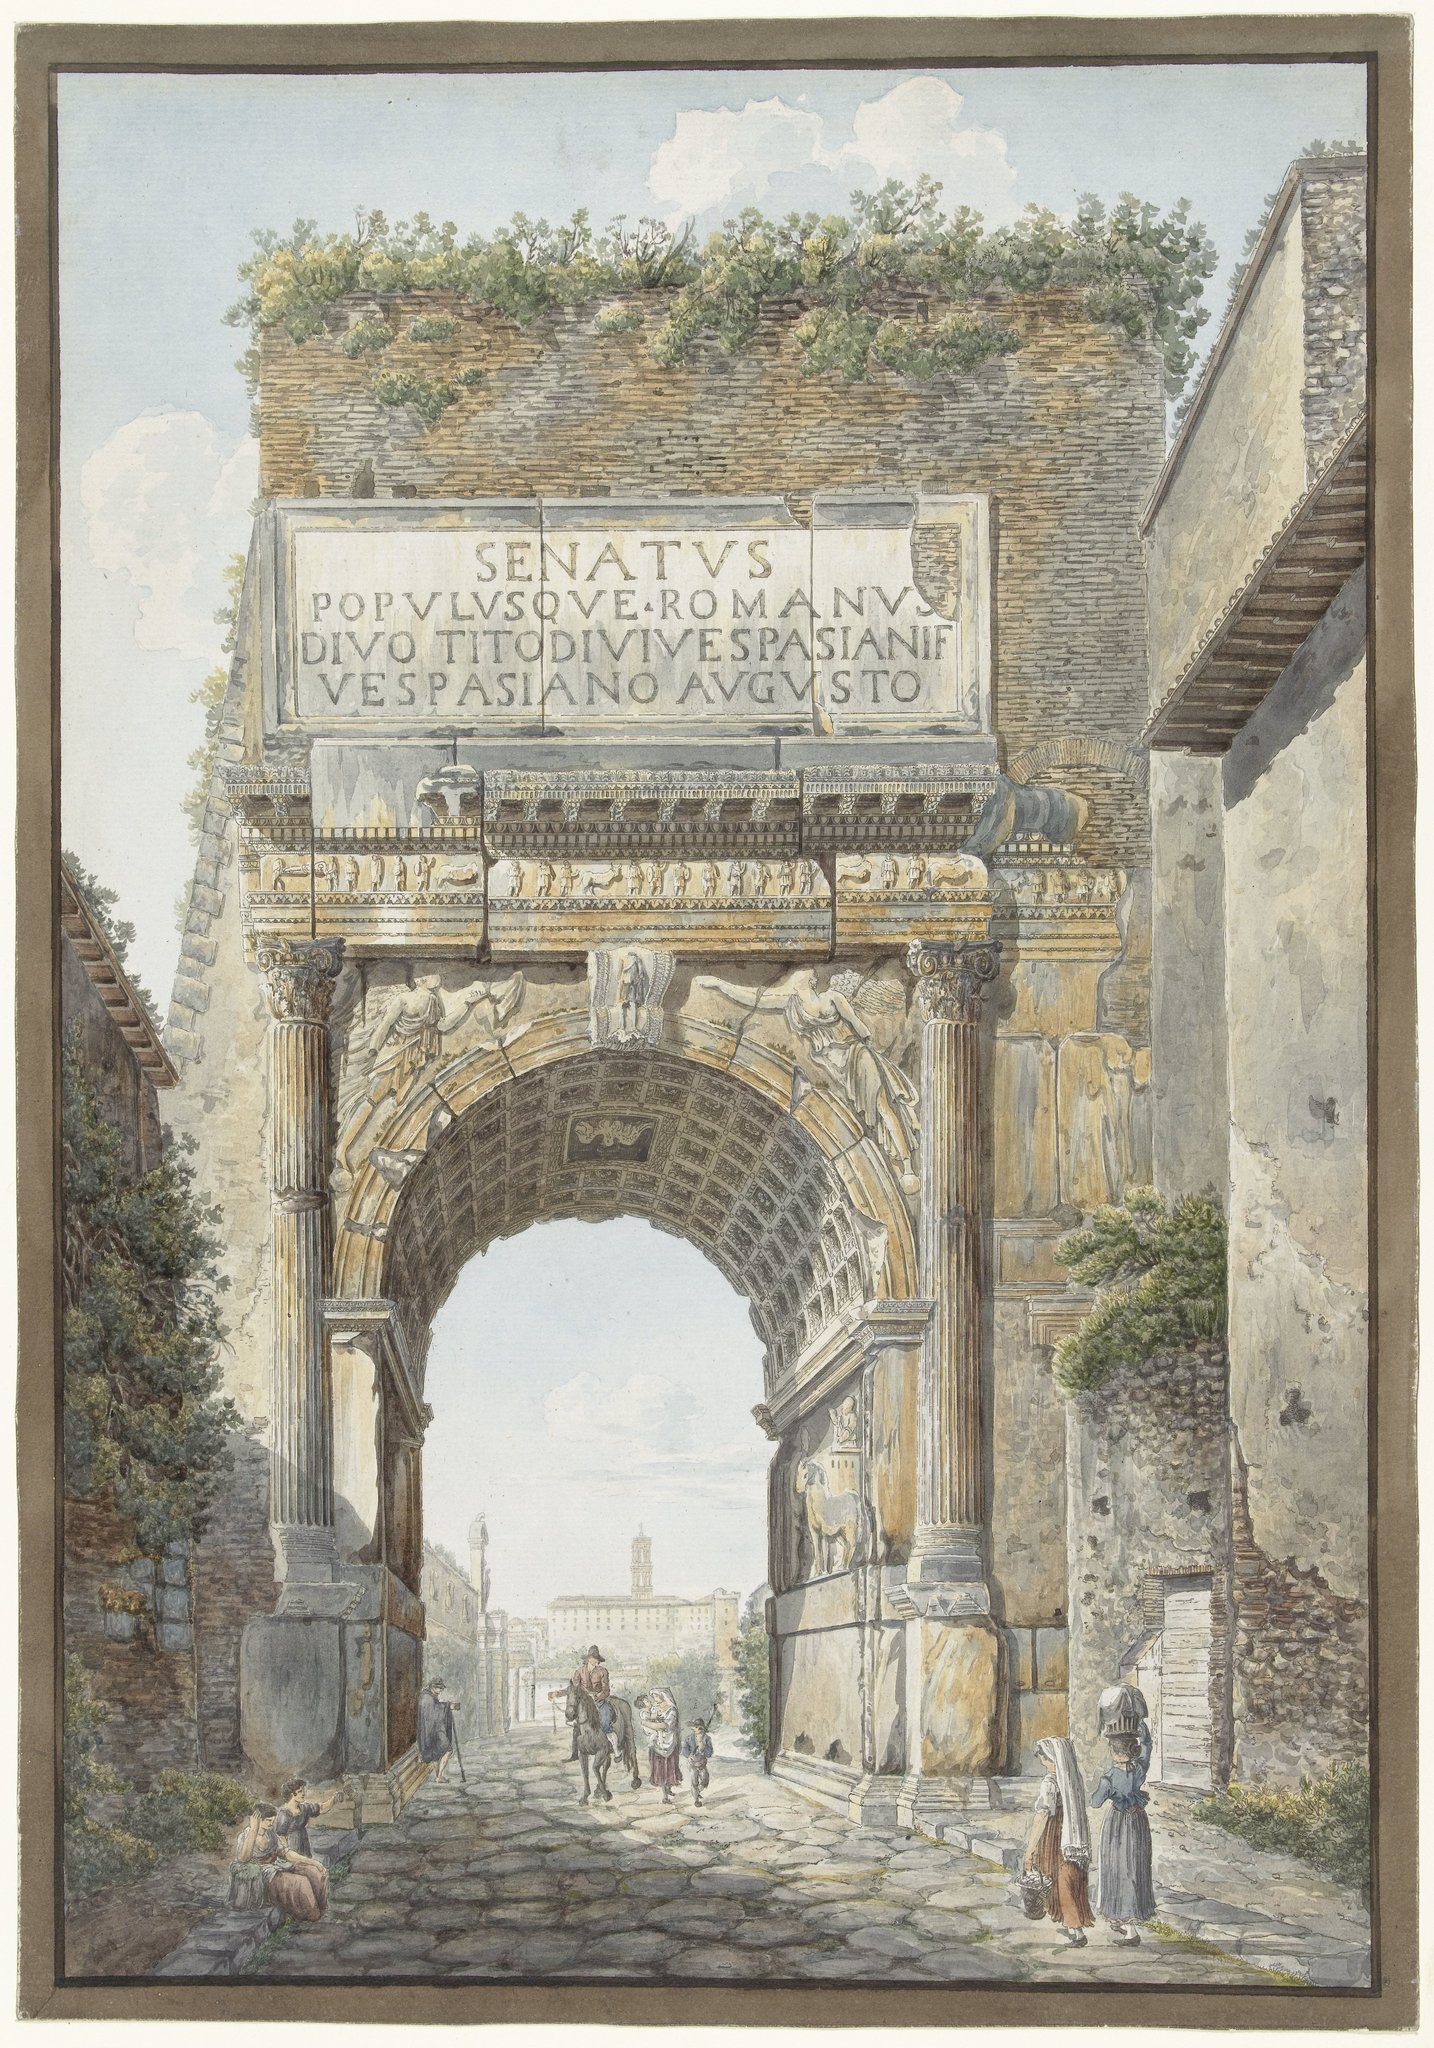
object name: print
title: De boog van Titus op het Forum Romanum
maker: daniël dupré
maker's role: draughtsman, print maker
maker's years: 1751-1817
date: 1786-1817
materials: paper, watercolor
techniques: etching, hand coloring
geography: netherlands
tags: triumphal arch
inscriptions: collector's mark: Lugt 2760, collector's mark: Lugt 2228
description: Gezicht op de boog van Titus op het Forum Romanum in Rome voor de restauratie en het herstel van de zijbeuken. Onder de poort staat een bedelaar. Een man te paard en een vrouw met twee kinderen lopen door de poort. Twee wasvrouwen lopen vanuit de andere kant op de poort af.